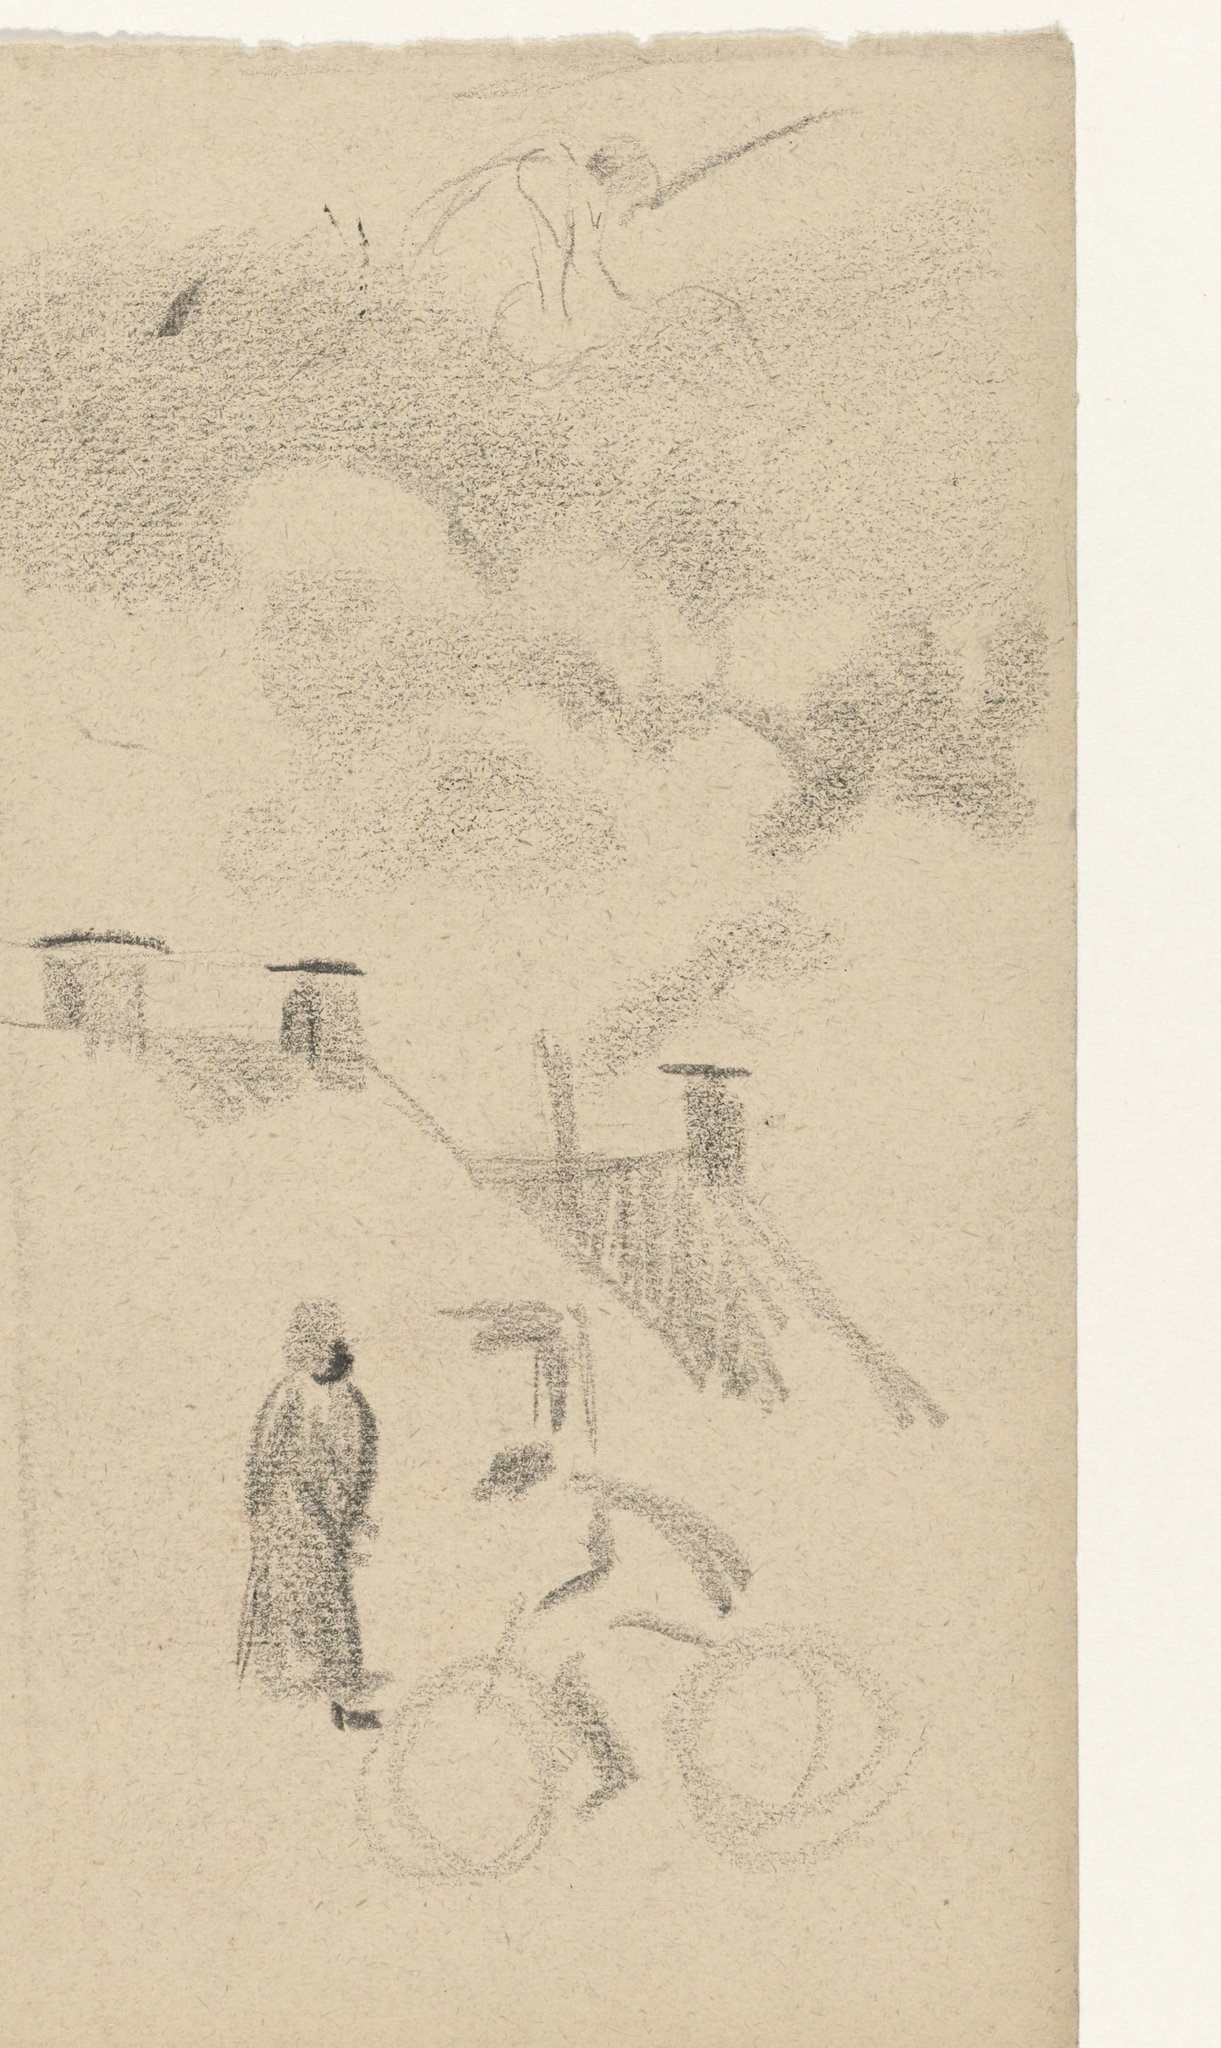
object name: drawing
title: Schets met fietser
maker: carel adolph lion cachet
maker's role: draughtsman, print maker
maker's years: 1864-1945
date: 1874-1945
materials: chalk, paper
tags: bicycle